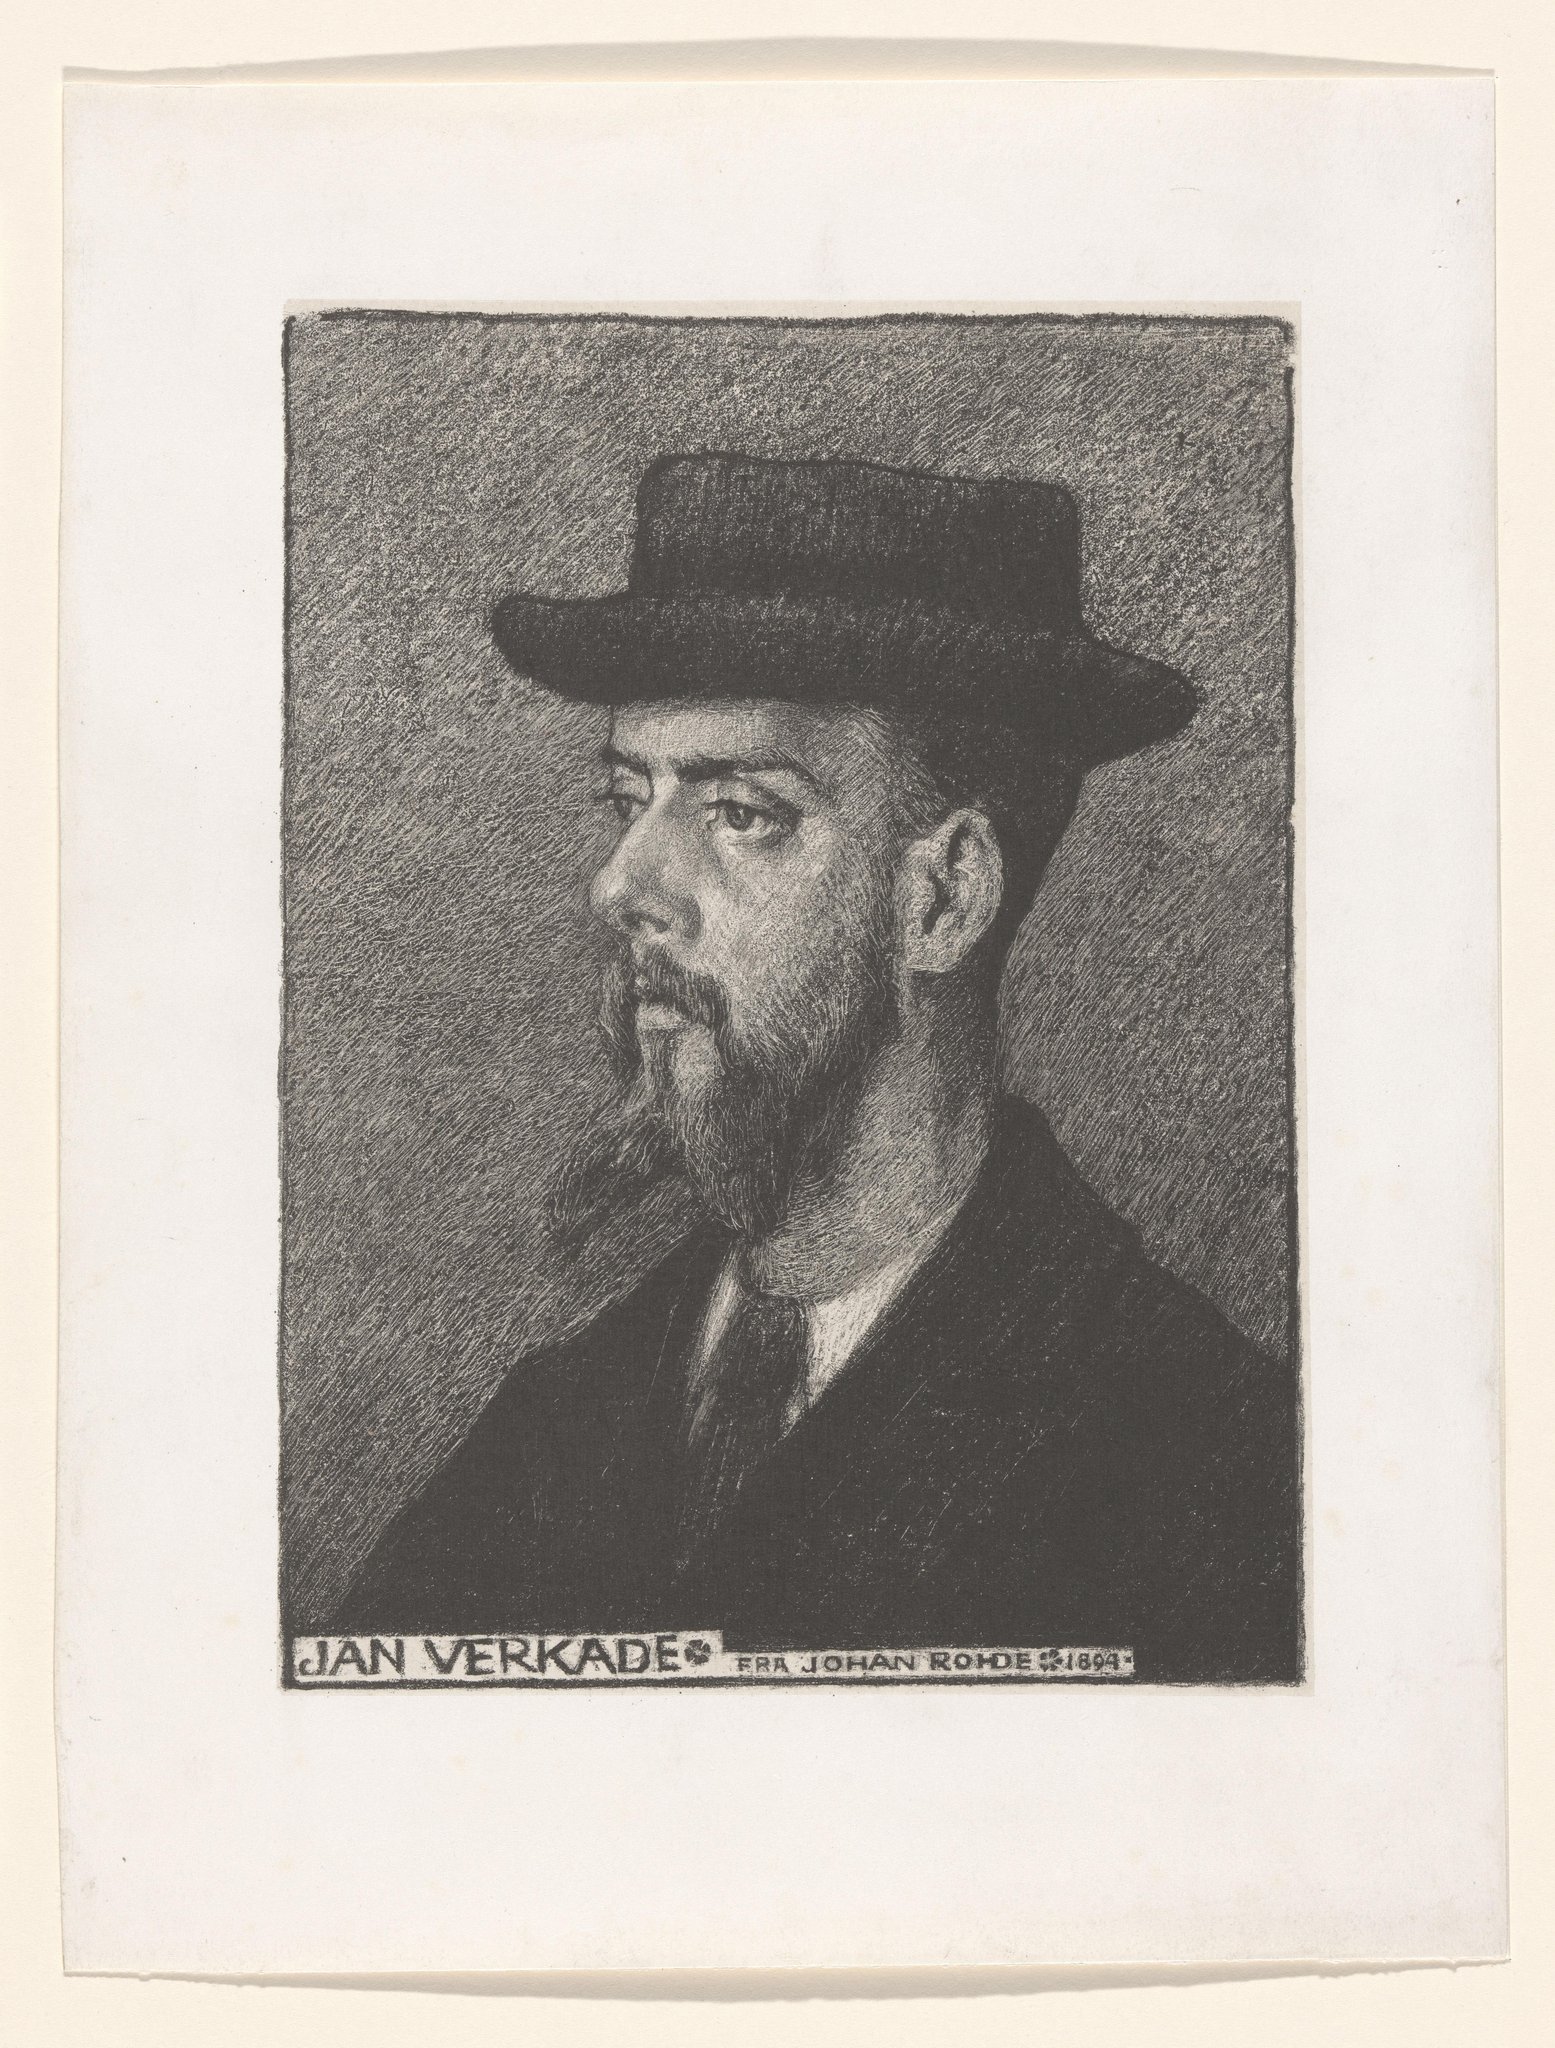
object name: print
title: Portret van Jan Verkade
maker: johan gudmann rohde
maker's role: designer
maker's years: 1856-1935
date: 1894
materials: ink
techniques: lithograph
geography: copenhagen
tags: painter, draughtsman, designer, jan verkade, historical persons, portrait, self-portrait of painter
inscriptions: collector's mark: Lugt 2228, collector's mark: Lugt 2760